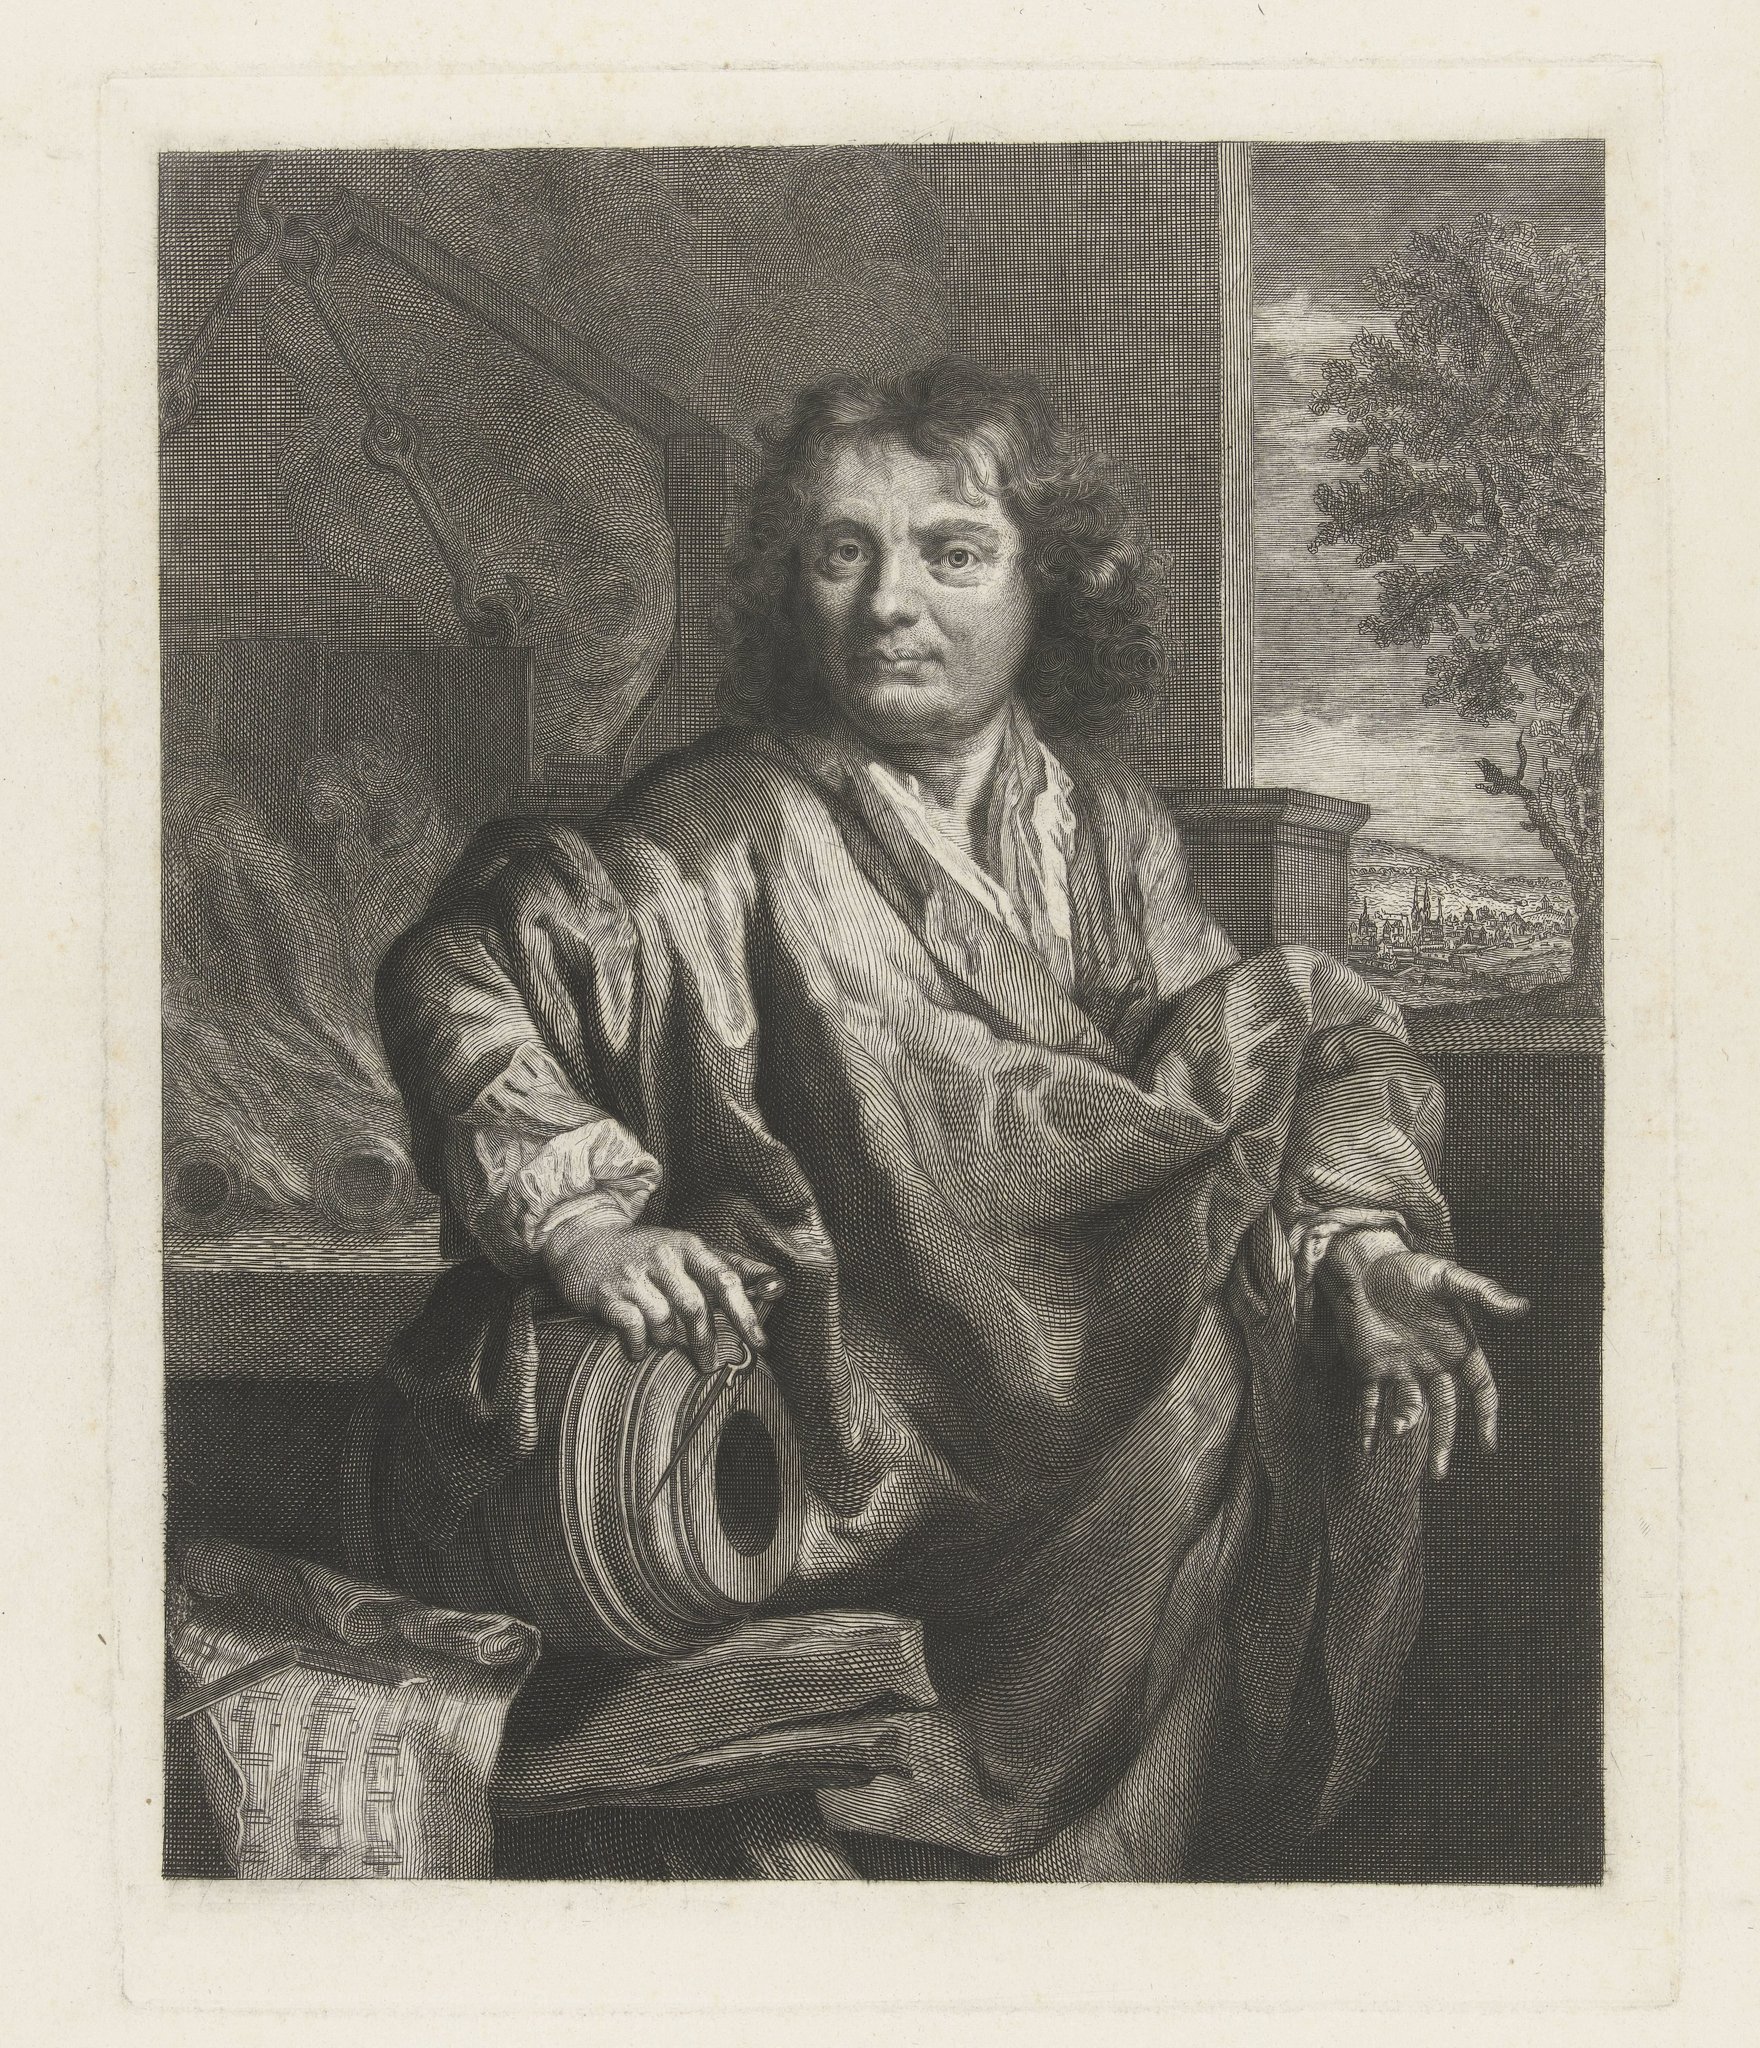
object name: print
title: Portret van een kanongieter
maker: petrus johannes arendzen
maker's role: draughtsman, print maker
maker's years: 1846-1932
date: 1866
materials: paper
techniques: engraving, etching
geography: netherlands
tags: firearms: cannon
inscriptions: inscription: ‘P.J. Arendzen April 1866’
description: Portret van een kanongieter. Links op de achtergrond worden kannonen gemaakt.